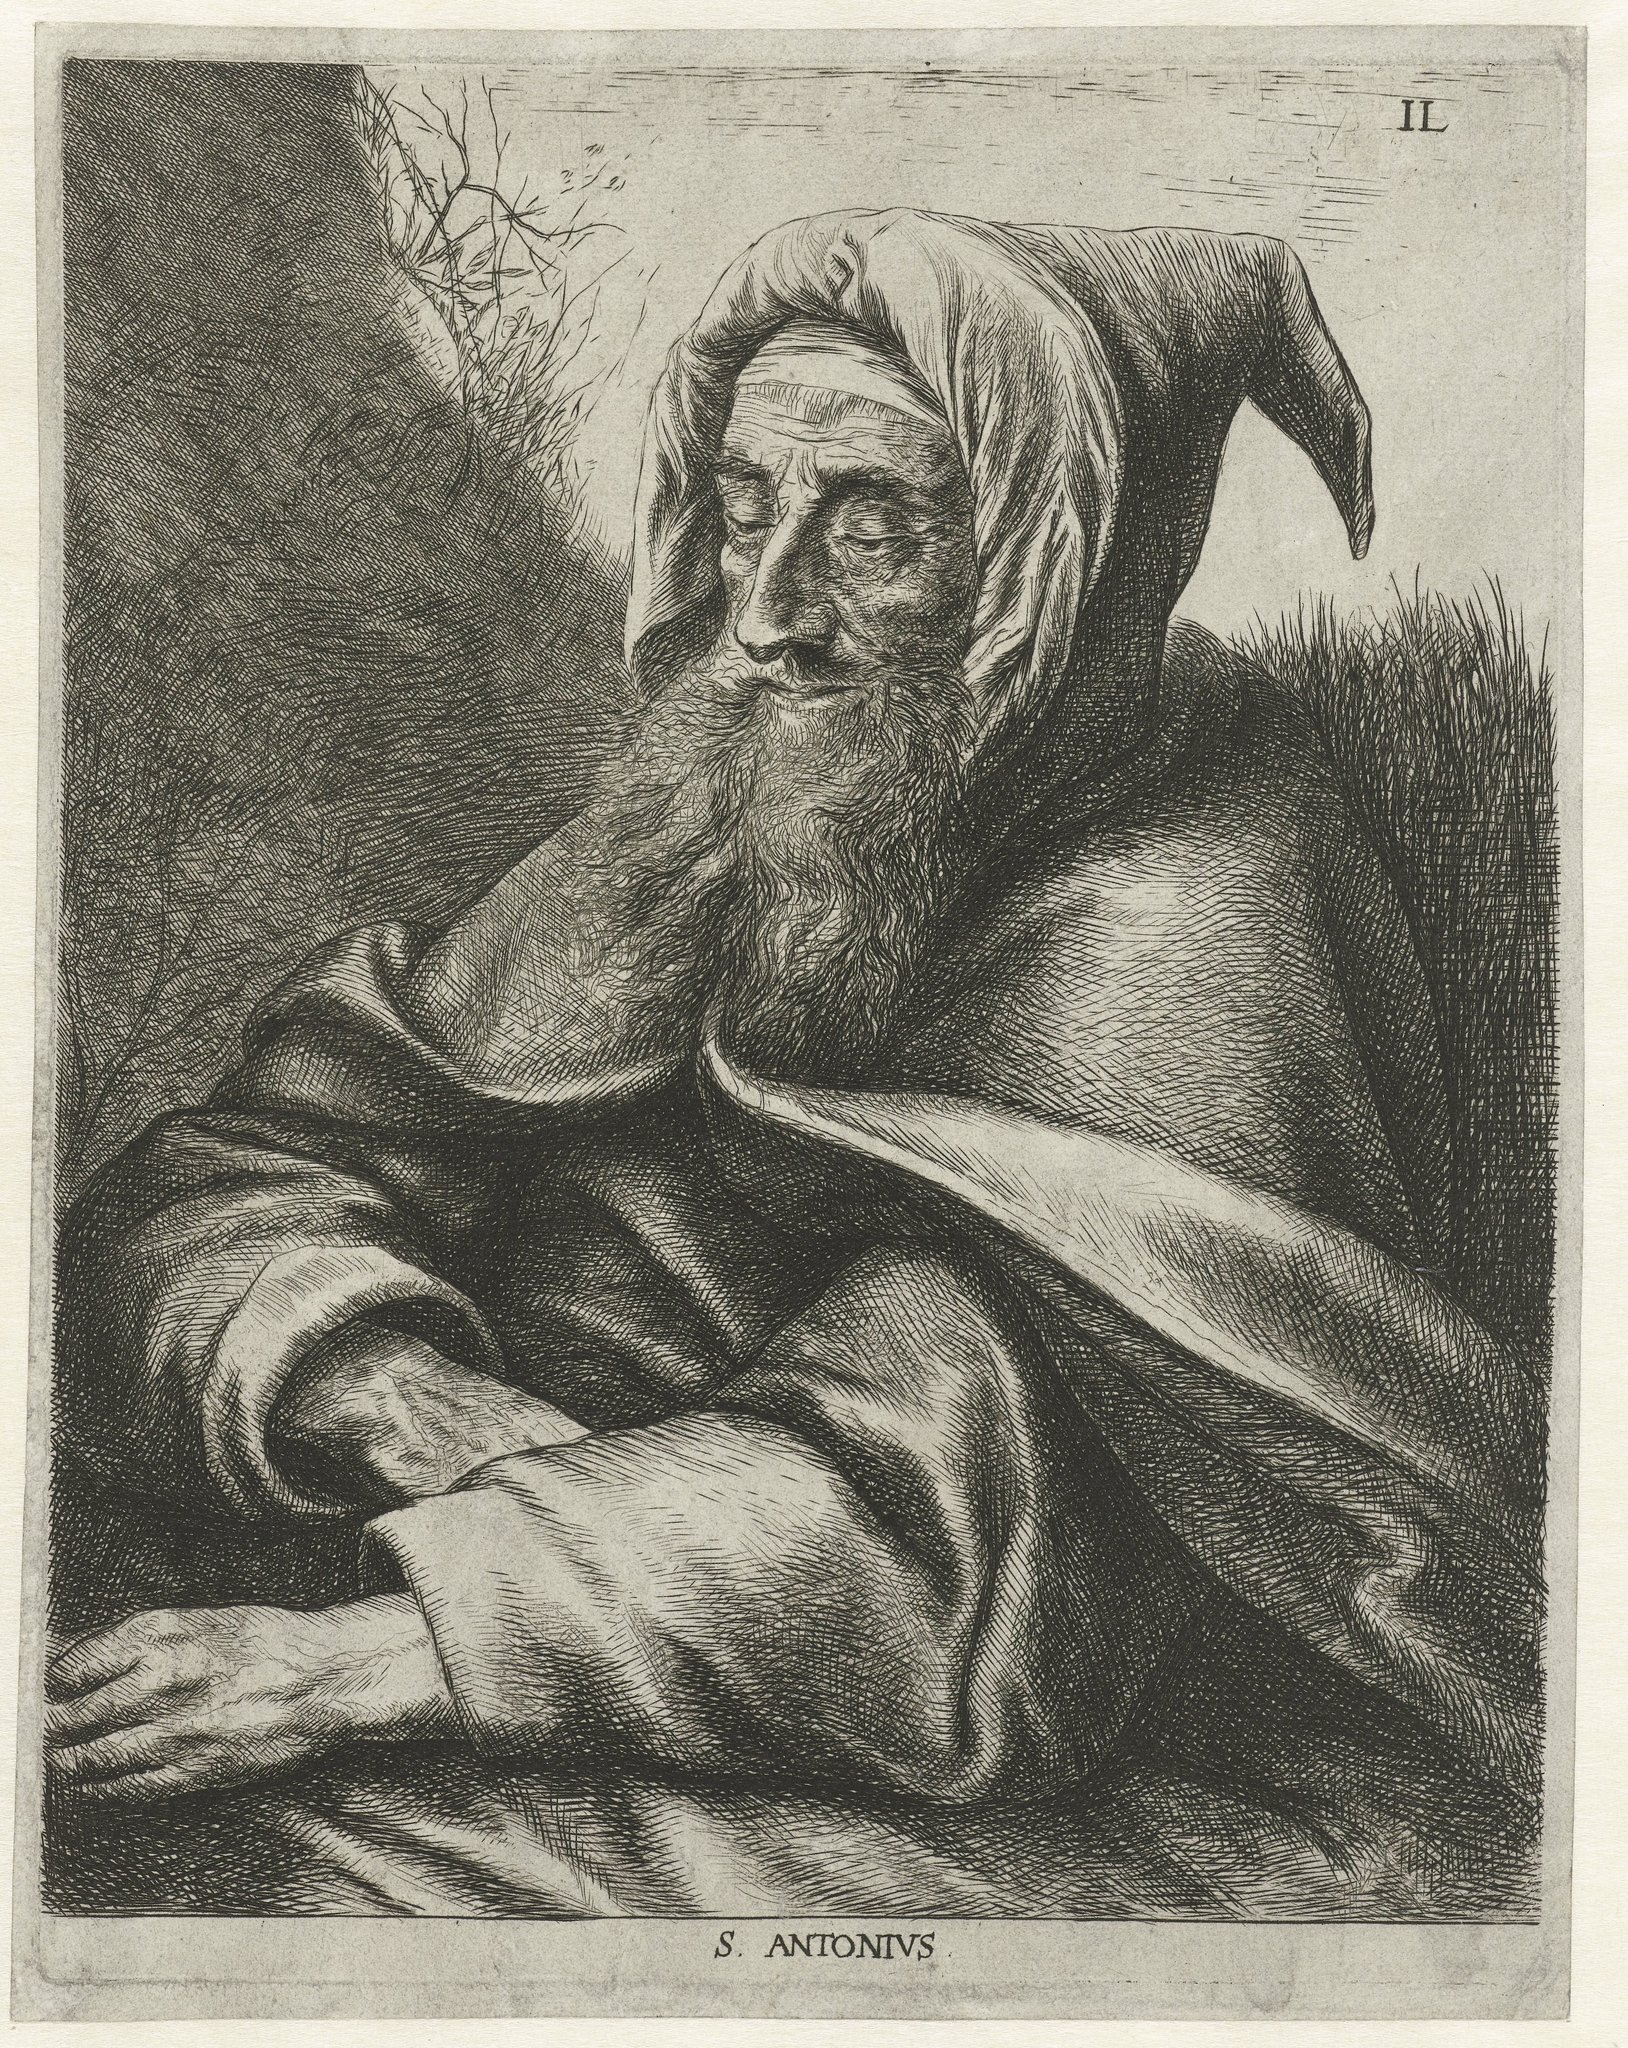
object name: print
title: S. Antonivs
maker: jan lievens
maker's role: draughtsman, painter, print maker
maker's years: 1607-1674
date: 1633-1638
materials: paper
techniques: engraving, etching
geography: netherlands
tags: the hermit antony abbot (antonius abbas) of egypt, also called the great; possible attributes: bell, book, t-shaped staff, flames, pig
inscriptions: collector's mark: Lugt 240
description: Halffiguur van de zittende Antonius de Grote (Antonius Abt) als oude man met een baard gekleed in een monnikspij.